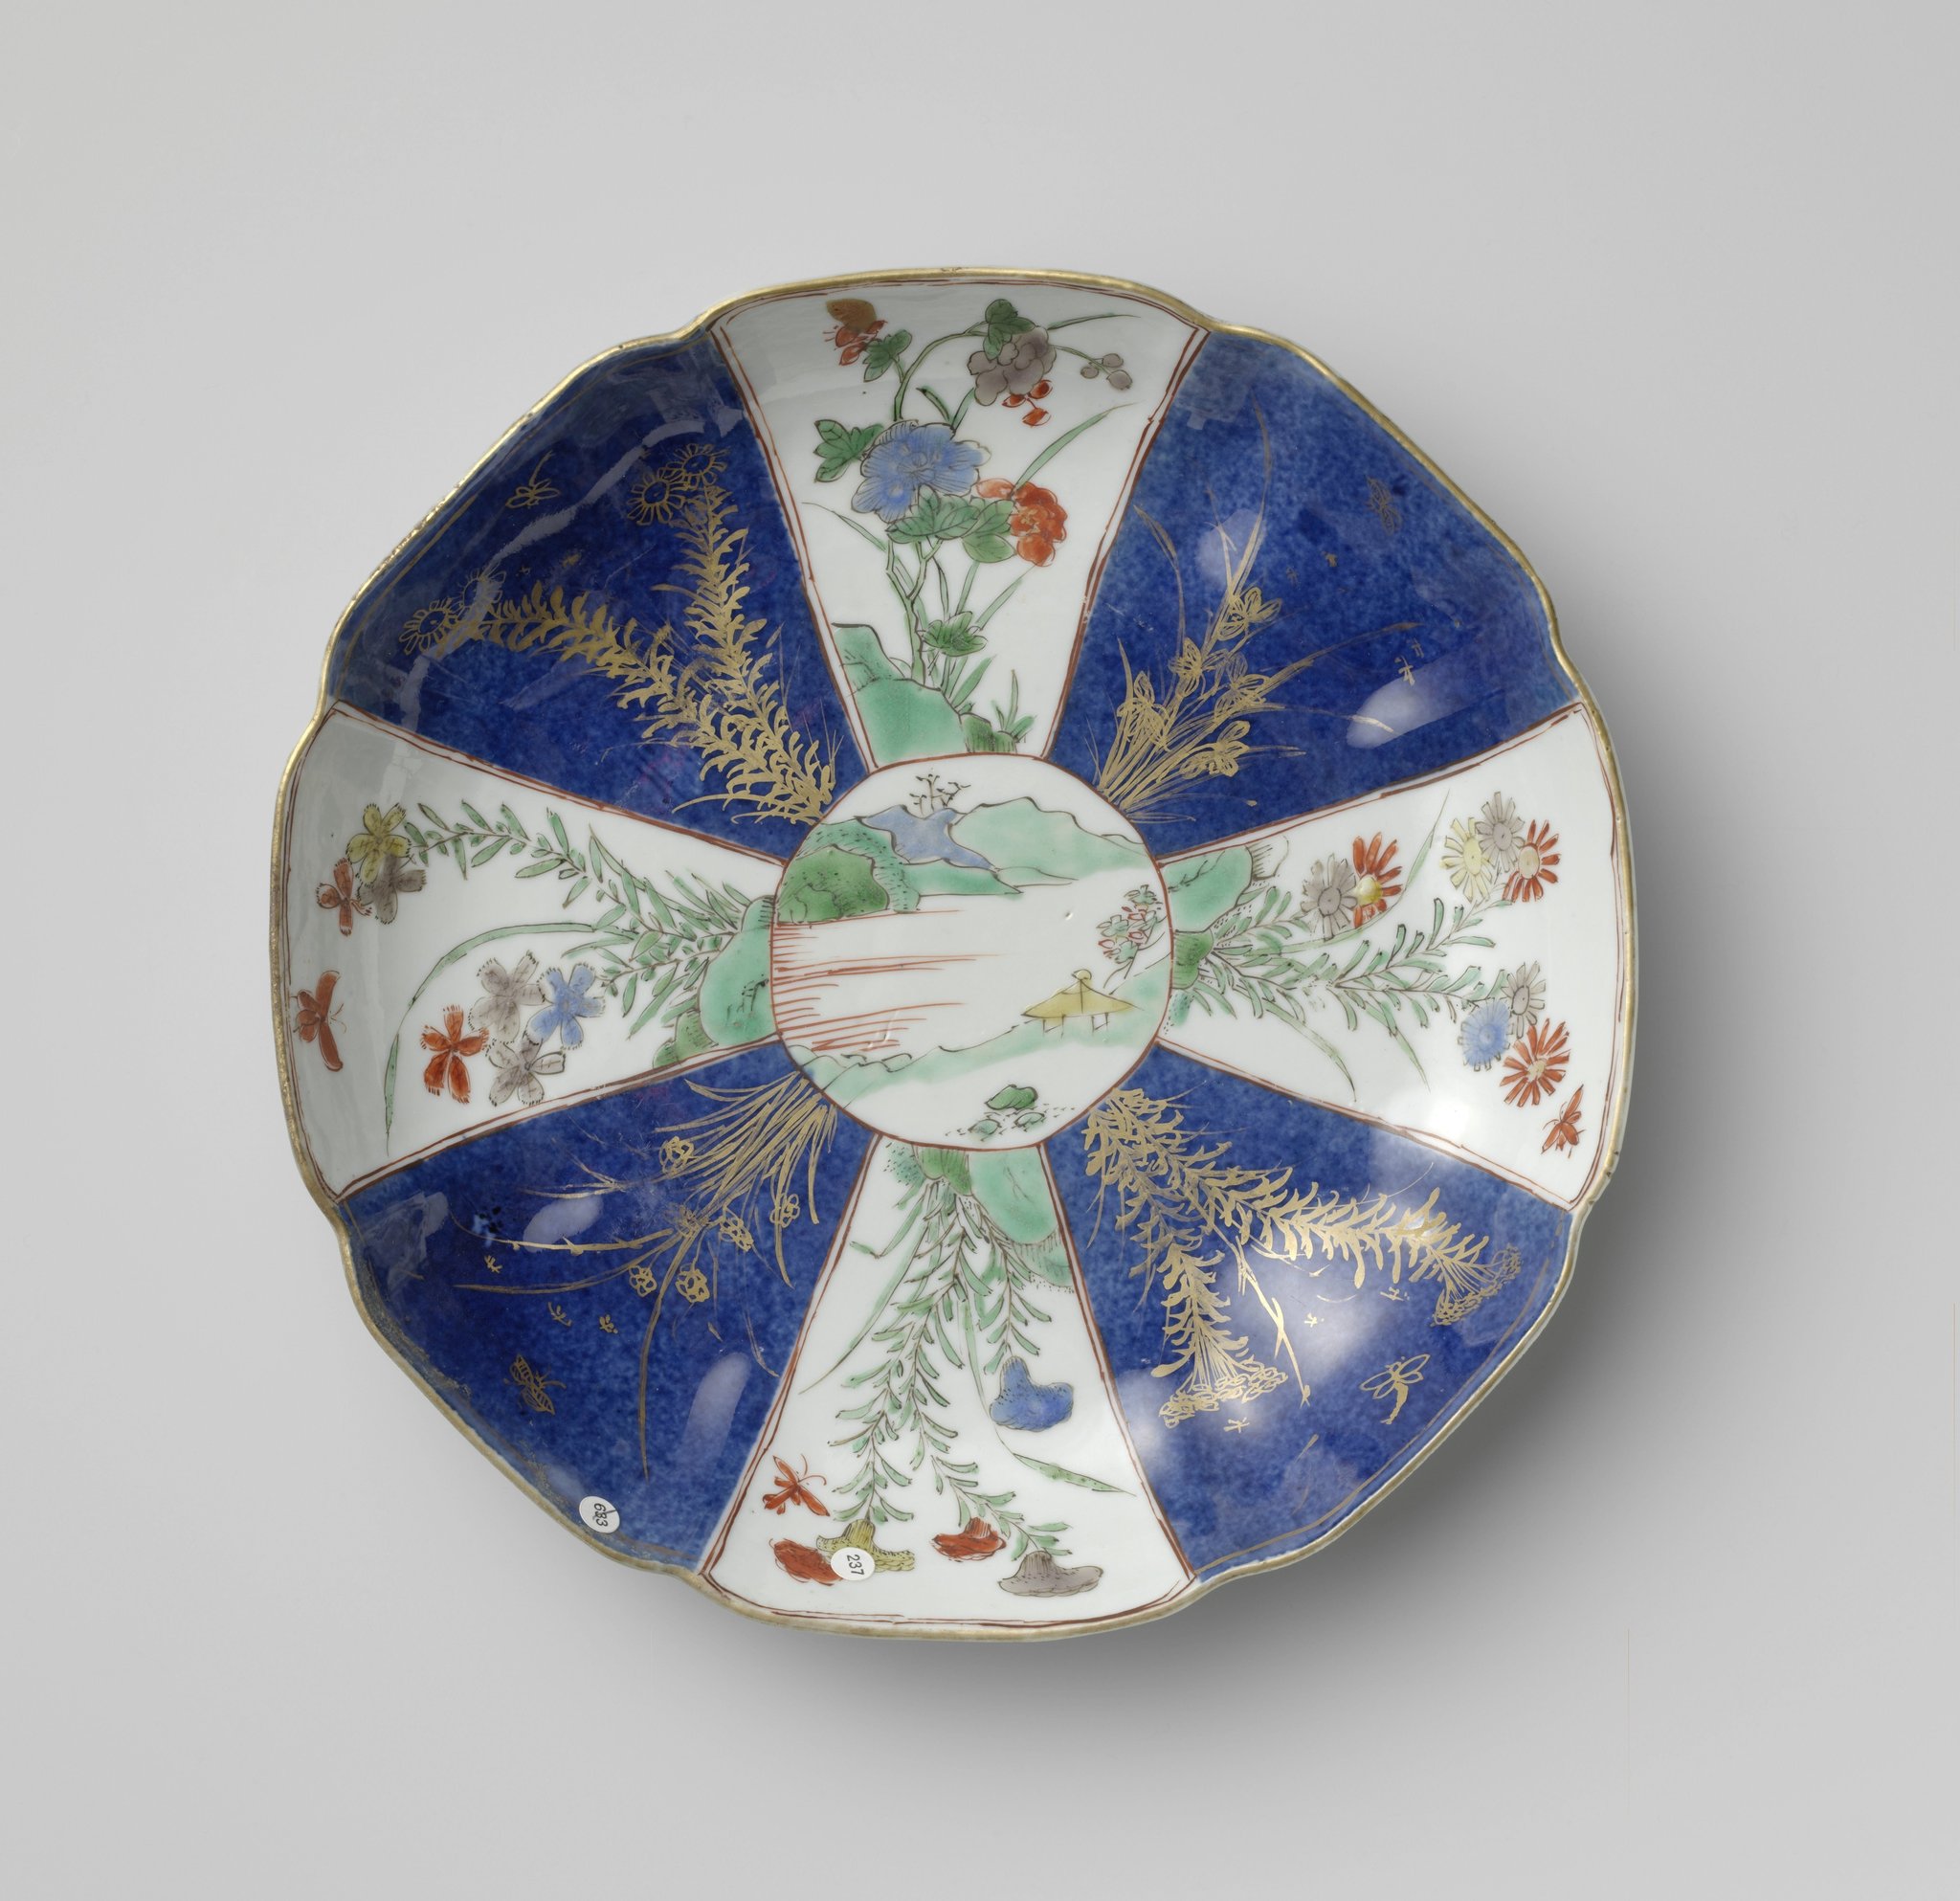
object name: platter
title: Saucer-dish in the shape of a flower with bleu poudré and panel decoration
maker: Anonymous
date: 1700-1724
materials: cobalt, glaze, gold, paint, porcelain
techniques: firing, gilding, turning, vitrification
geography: china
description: Schotel van porselein met ronde, gelobde wand en geschulpte rand in de vorm van een bloem, beschilderd in onderglazuur blauw en op het glazuur blauw, rood, groen, geel, aubergine, zwart en goud met een vakdecoratie. Op het plat een medaillon met rivierlandschap met paviljoen, rotsen en bomen; de wand is gemodelleerd in acht bloembladeren afwisselend gevuld met een bloemtak en vlinder in goud op een bleu poudré (poederblauw) grond en een bloemtak op een rots met vlinder op ene witte grond. Bleu poudré met famille verte.